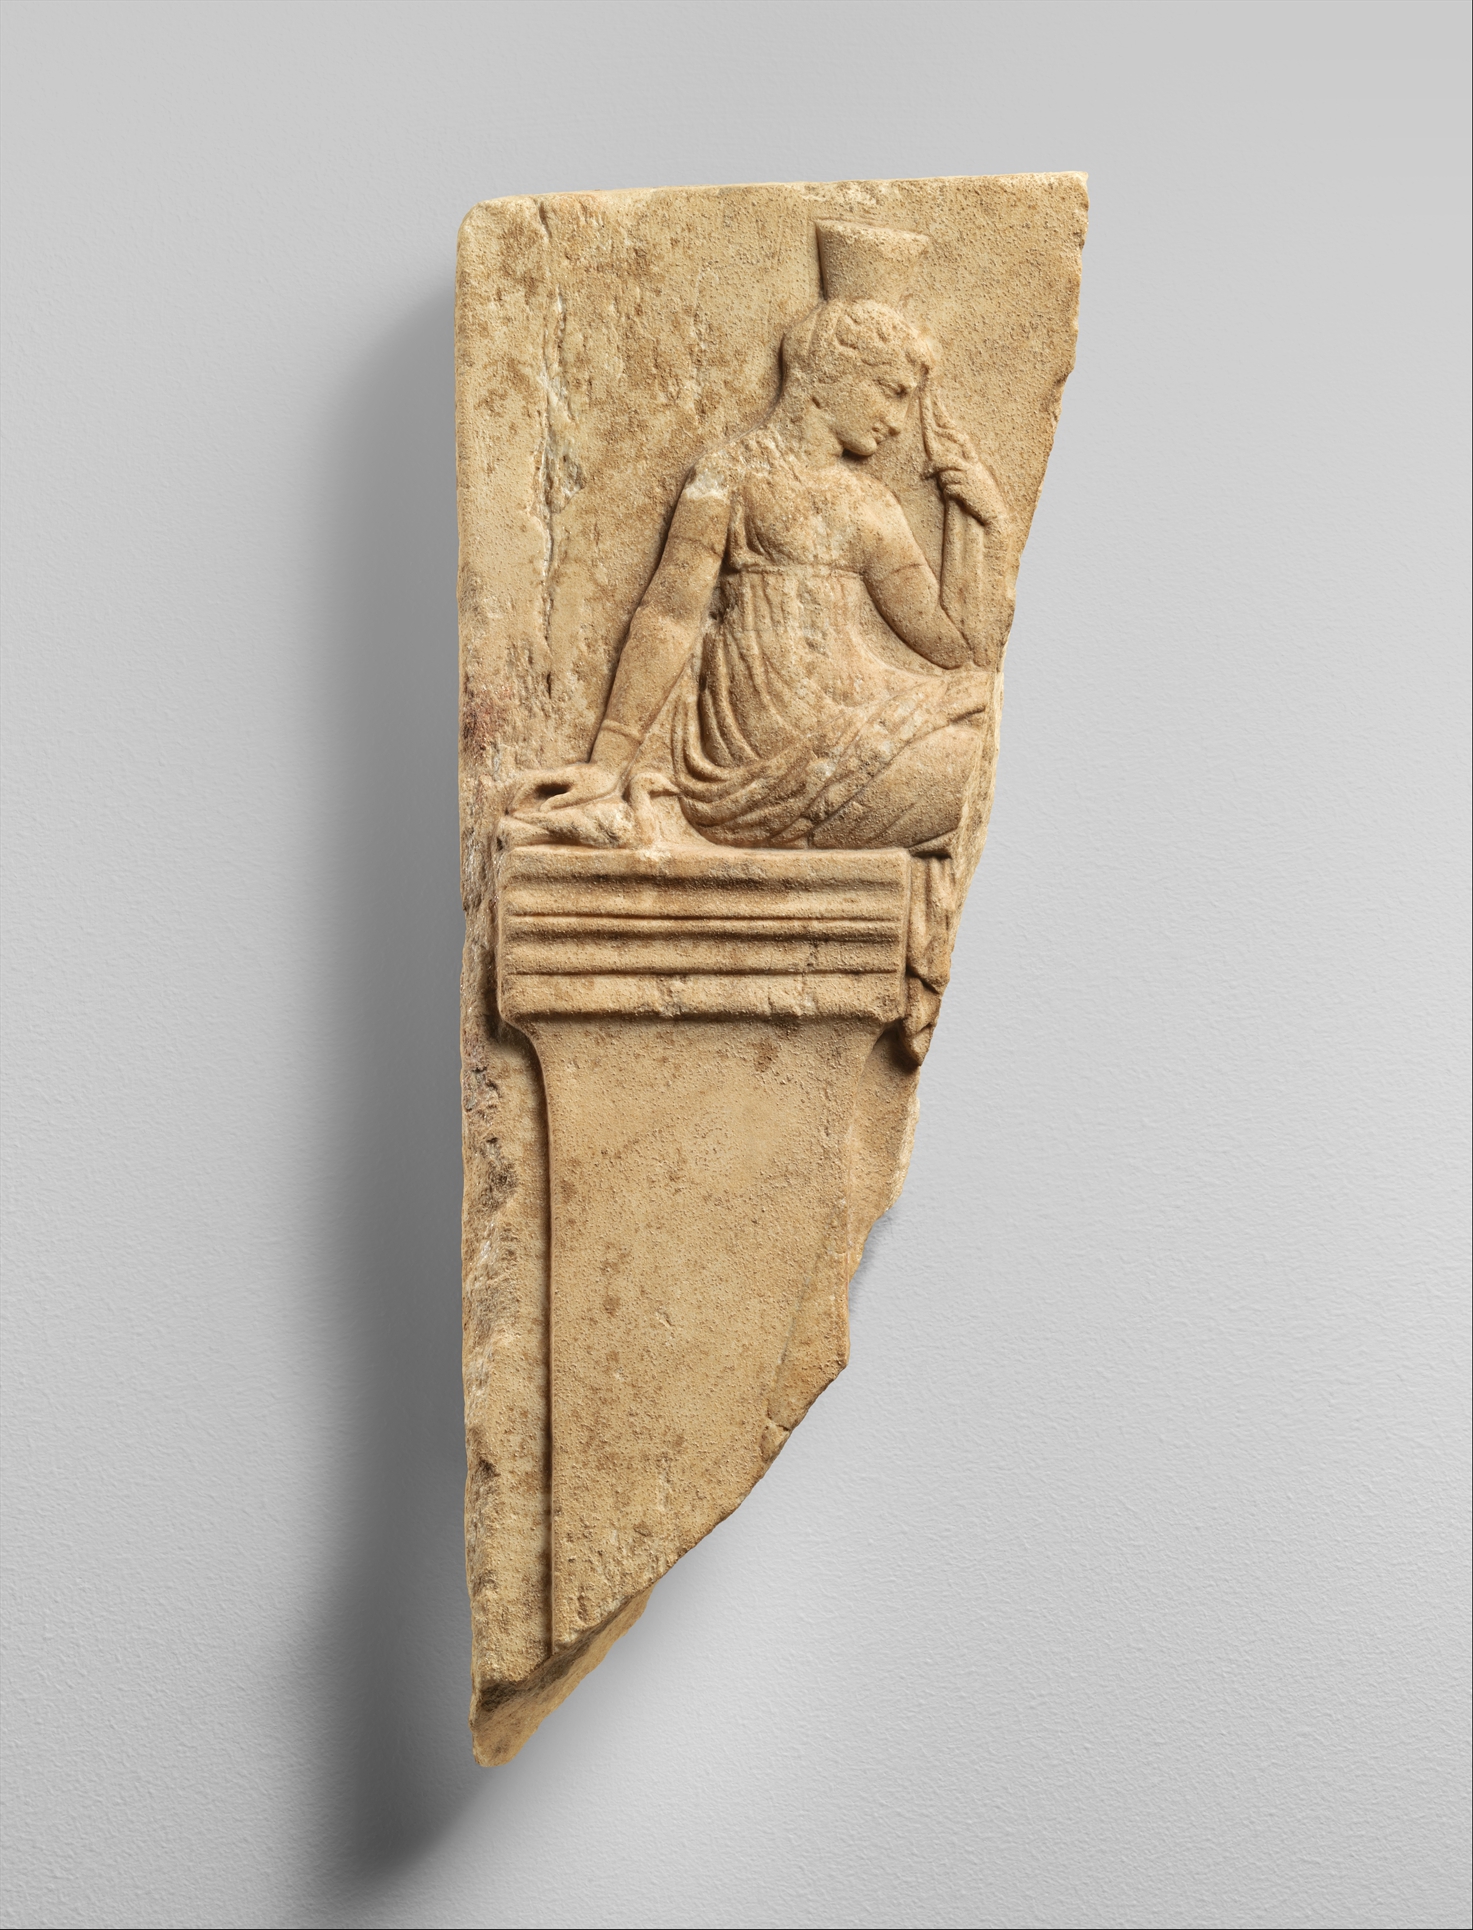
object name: relief fragment with peitho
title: Fragment of a marble neo-Attic relief with Peitho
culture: roman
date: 100-1 BCE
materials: marble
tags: doves,women